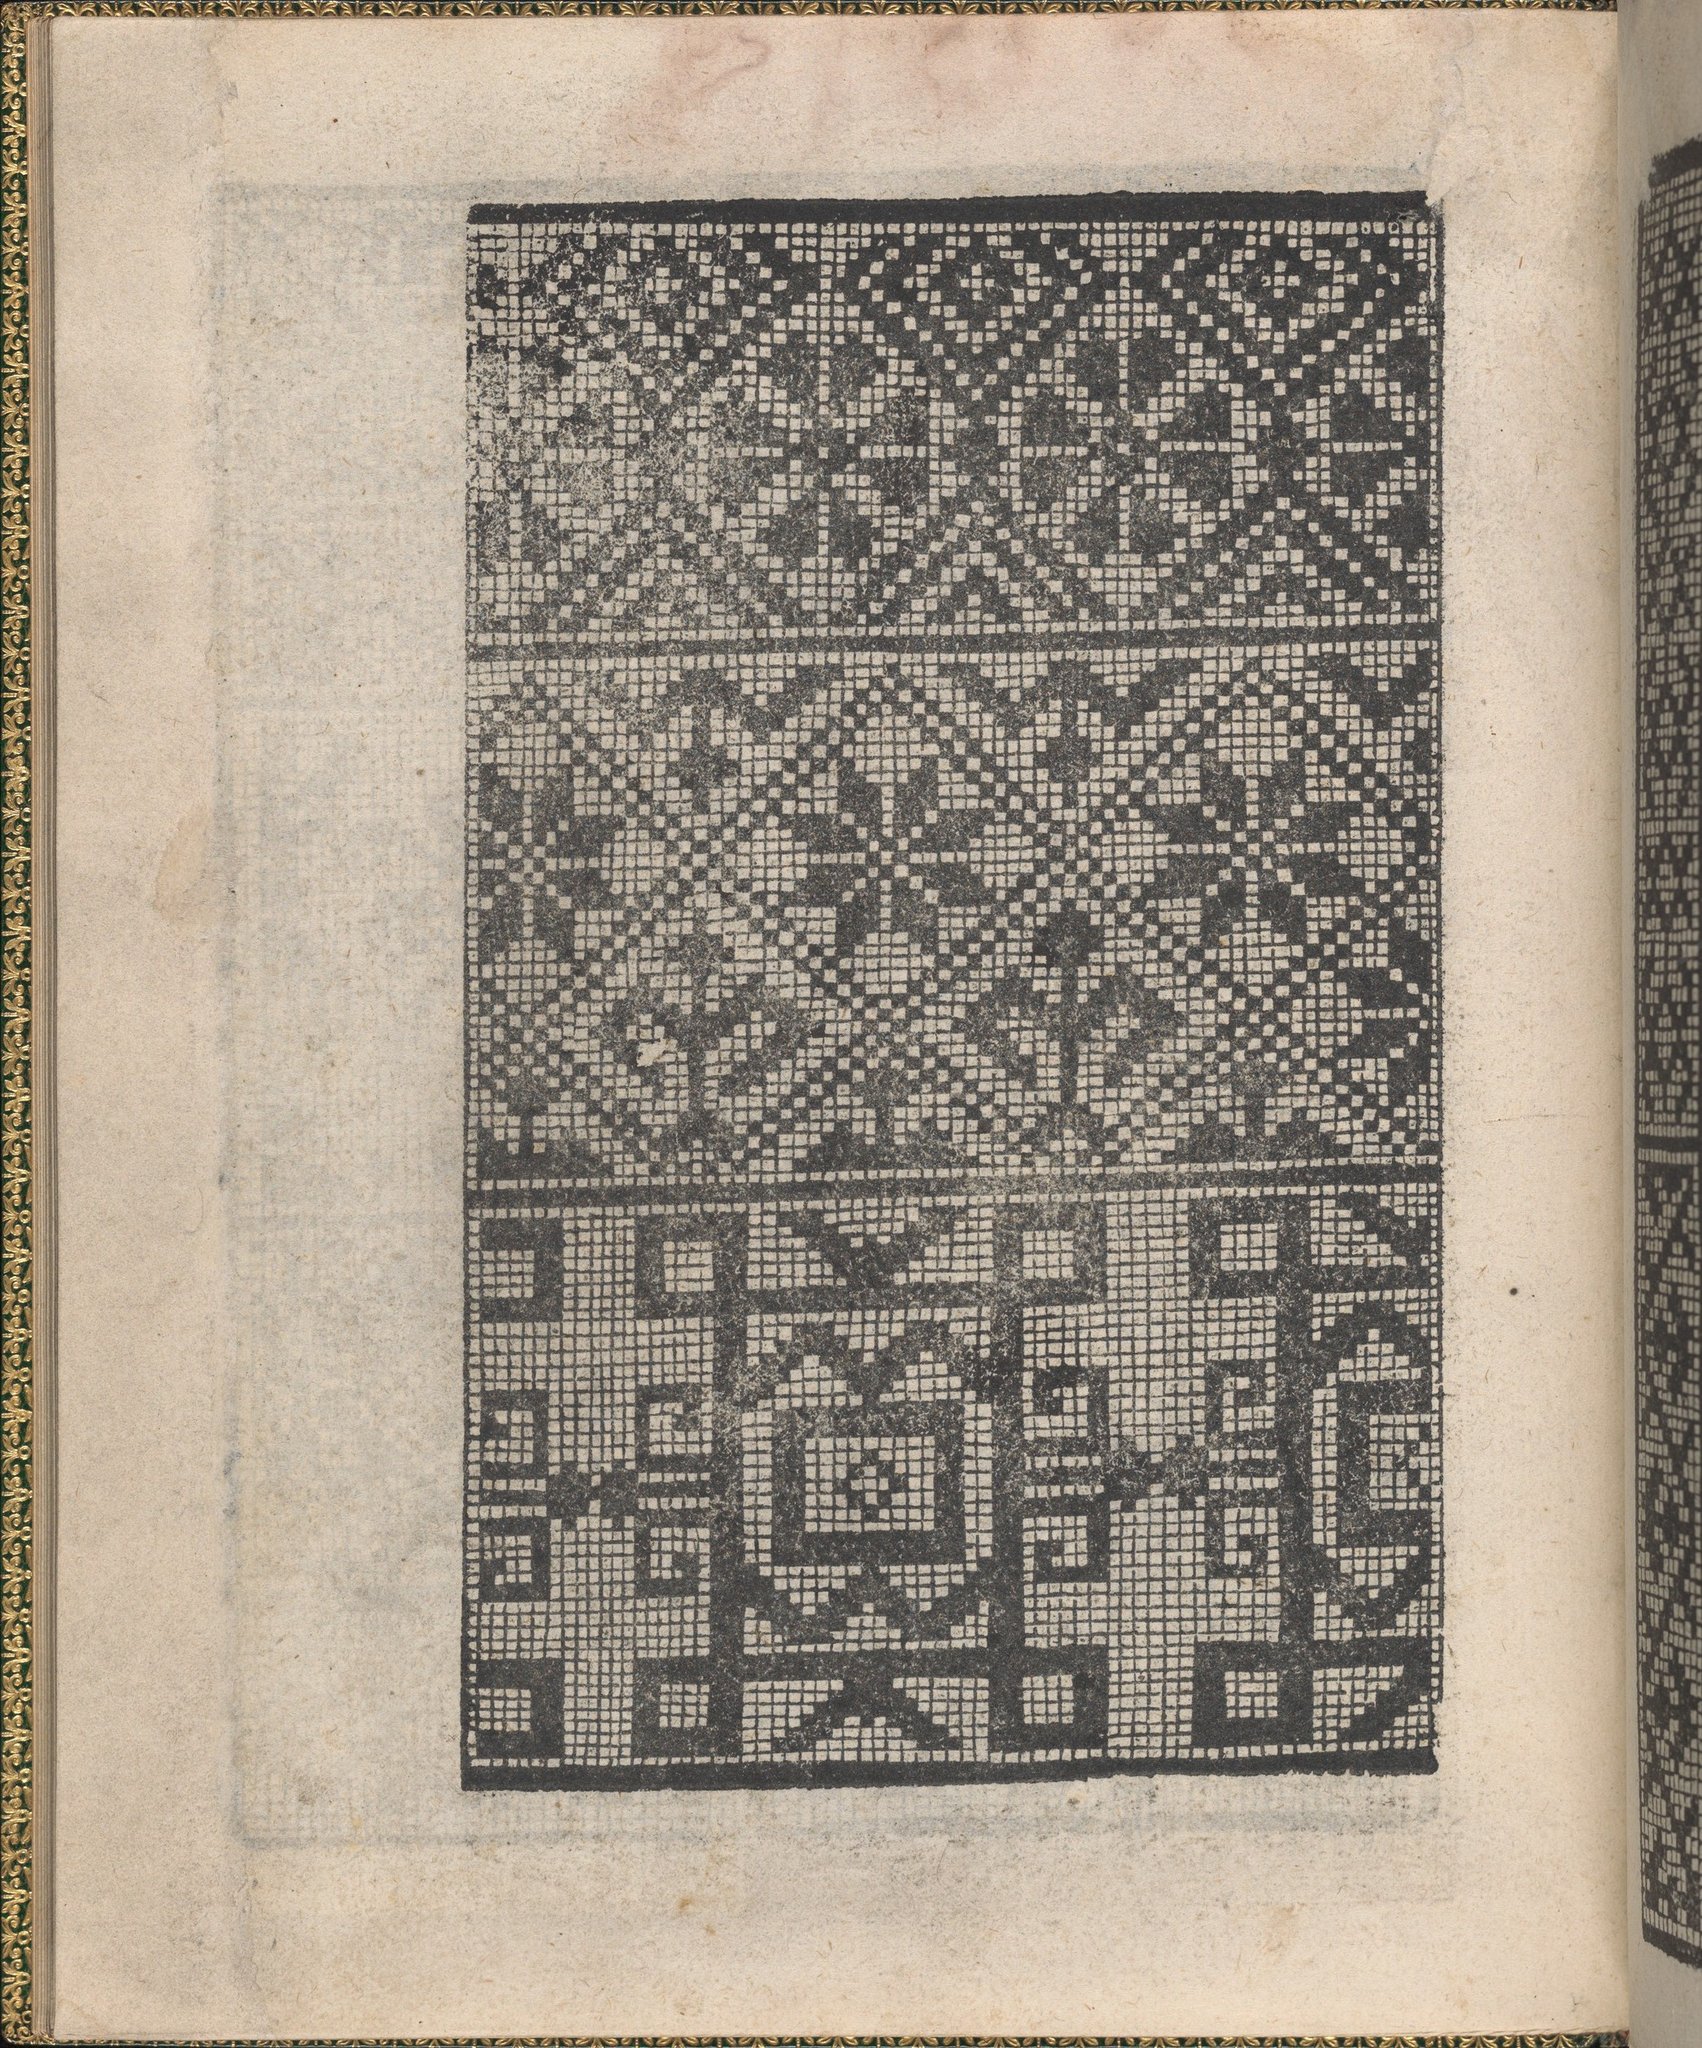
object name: book print ornament architecture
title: Ornamento delle belle & virtuose donne, page 14 (verso)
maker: matteo pagano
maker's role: publisher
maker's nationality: italian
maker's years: 1515-1588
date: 1554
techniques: woodcut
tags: flowers